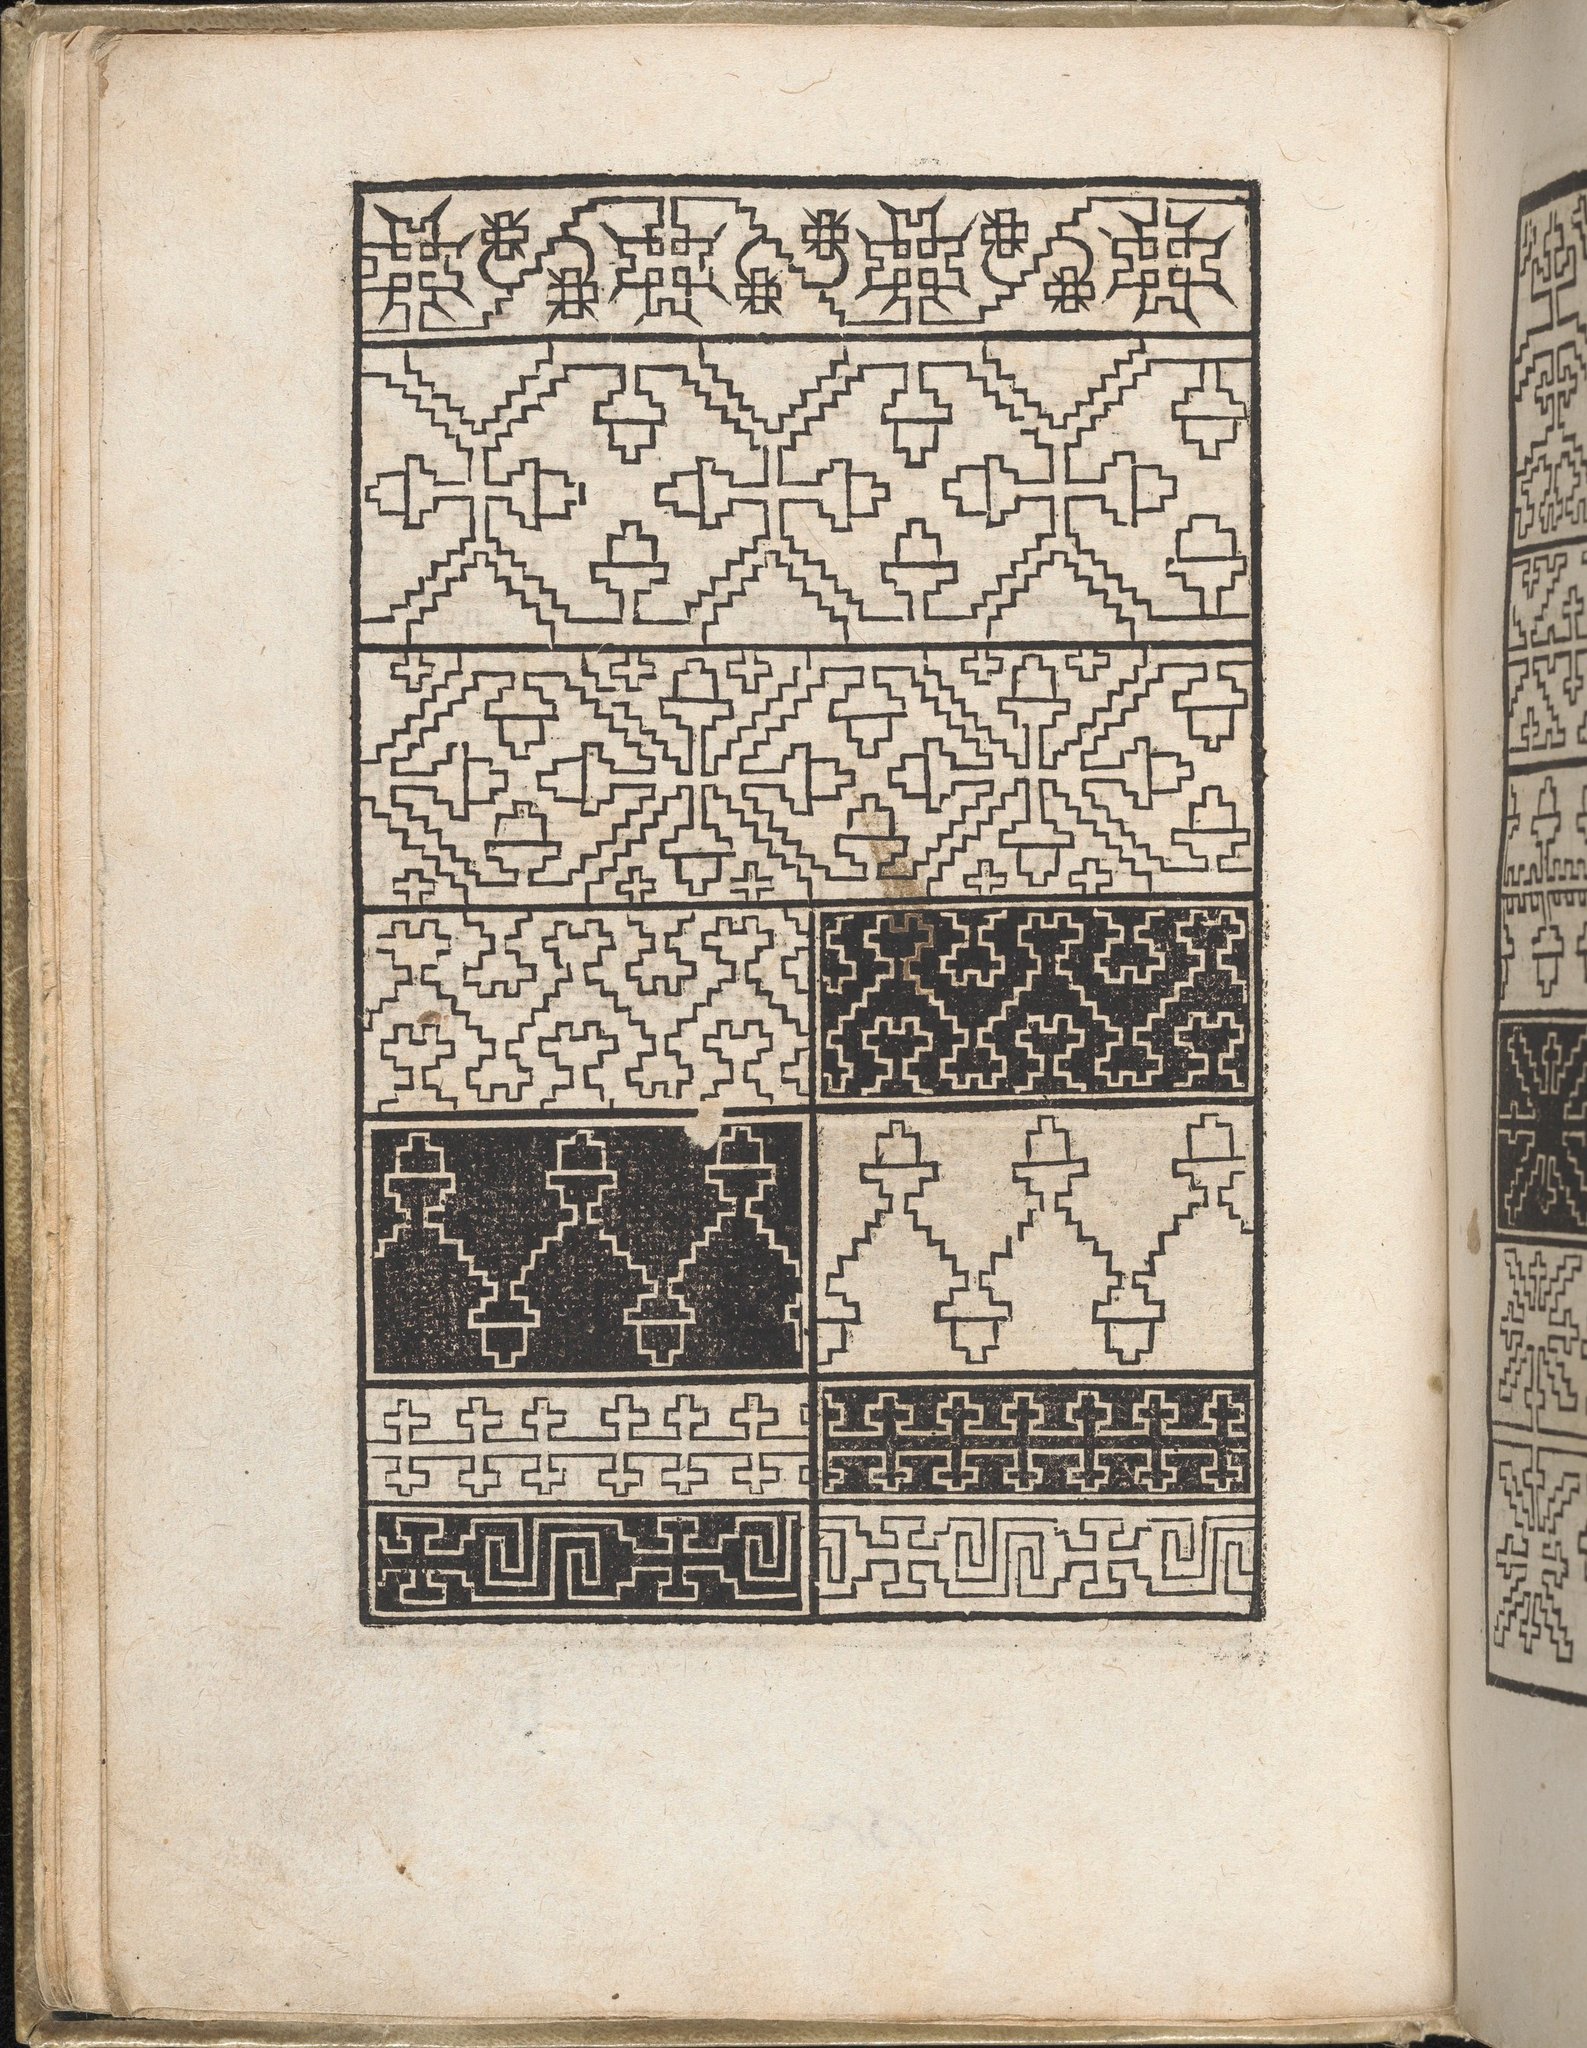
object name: book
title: Page 6v, from "Eyn New Kunstlichboich"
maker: peter quentel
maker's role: publisher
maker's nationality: german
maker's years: 1500-1550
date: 1529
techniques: woodcut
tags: ornament